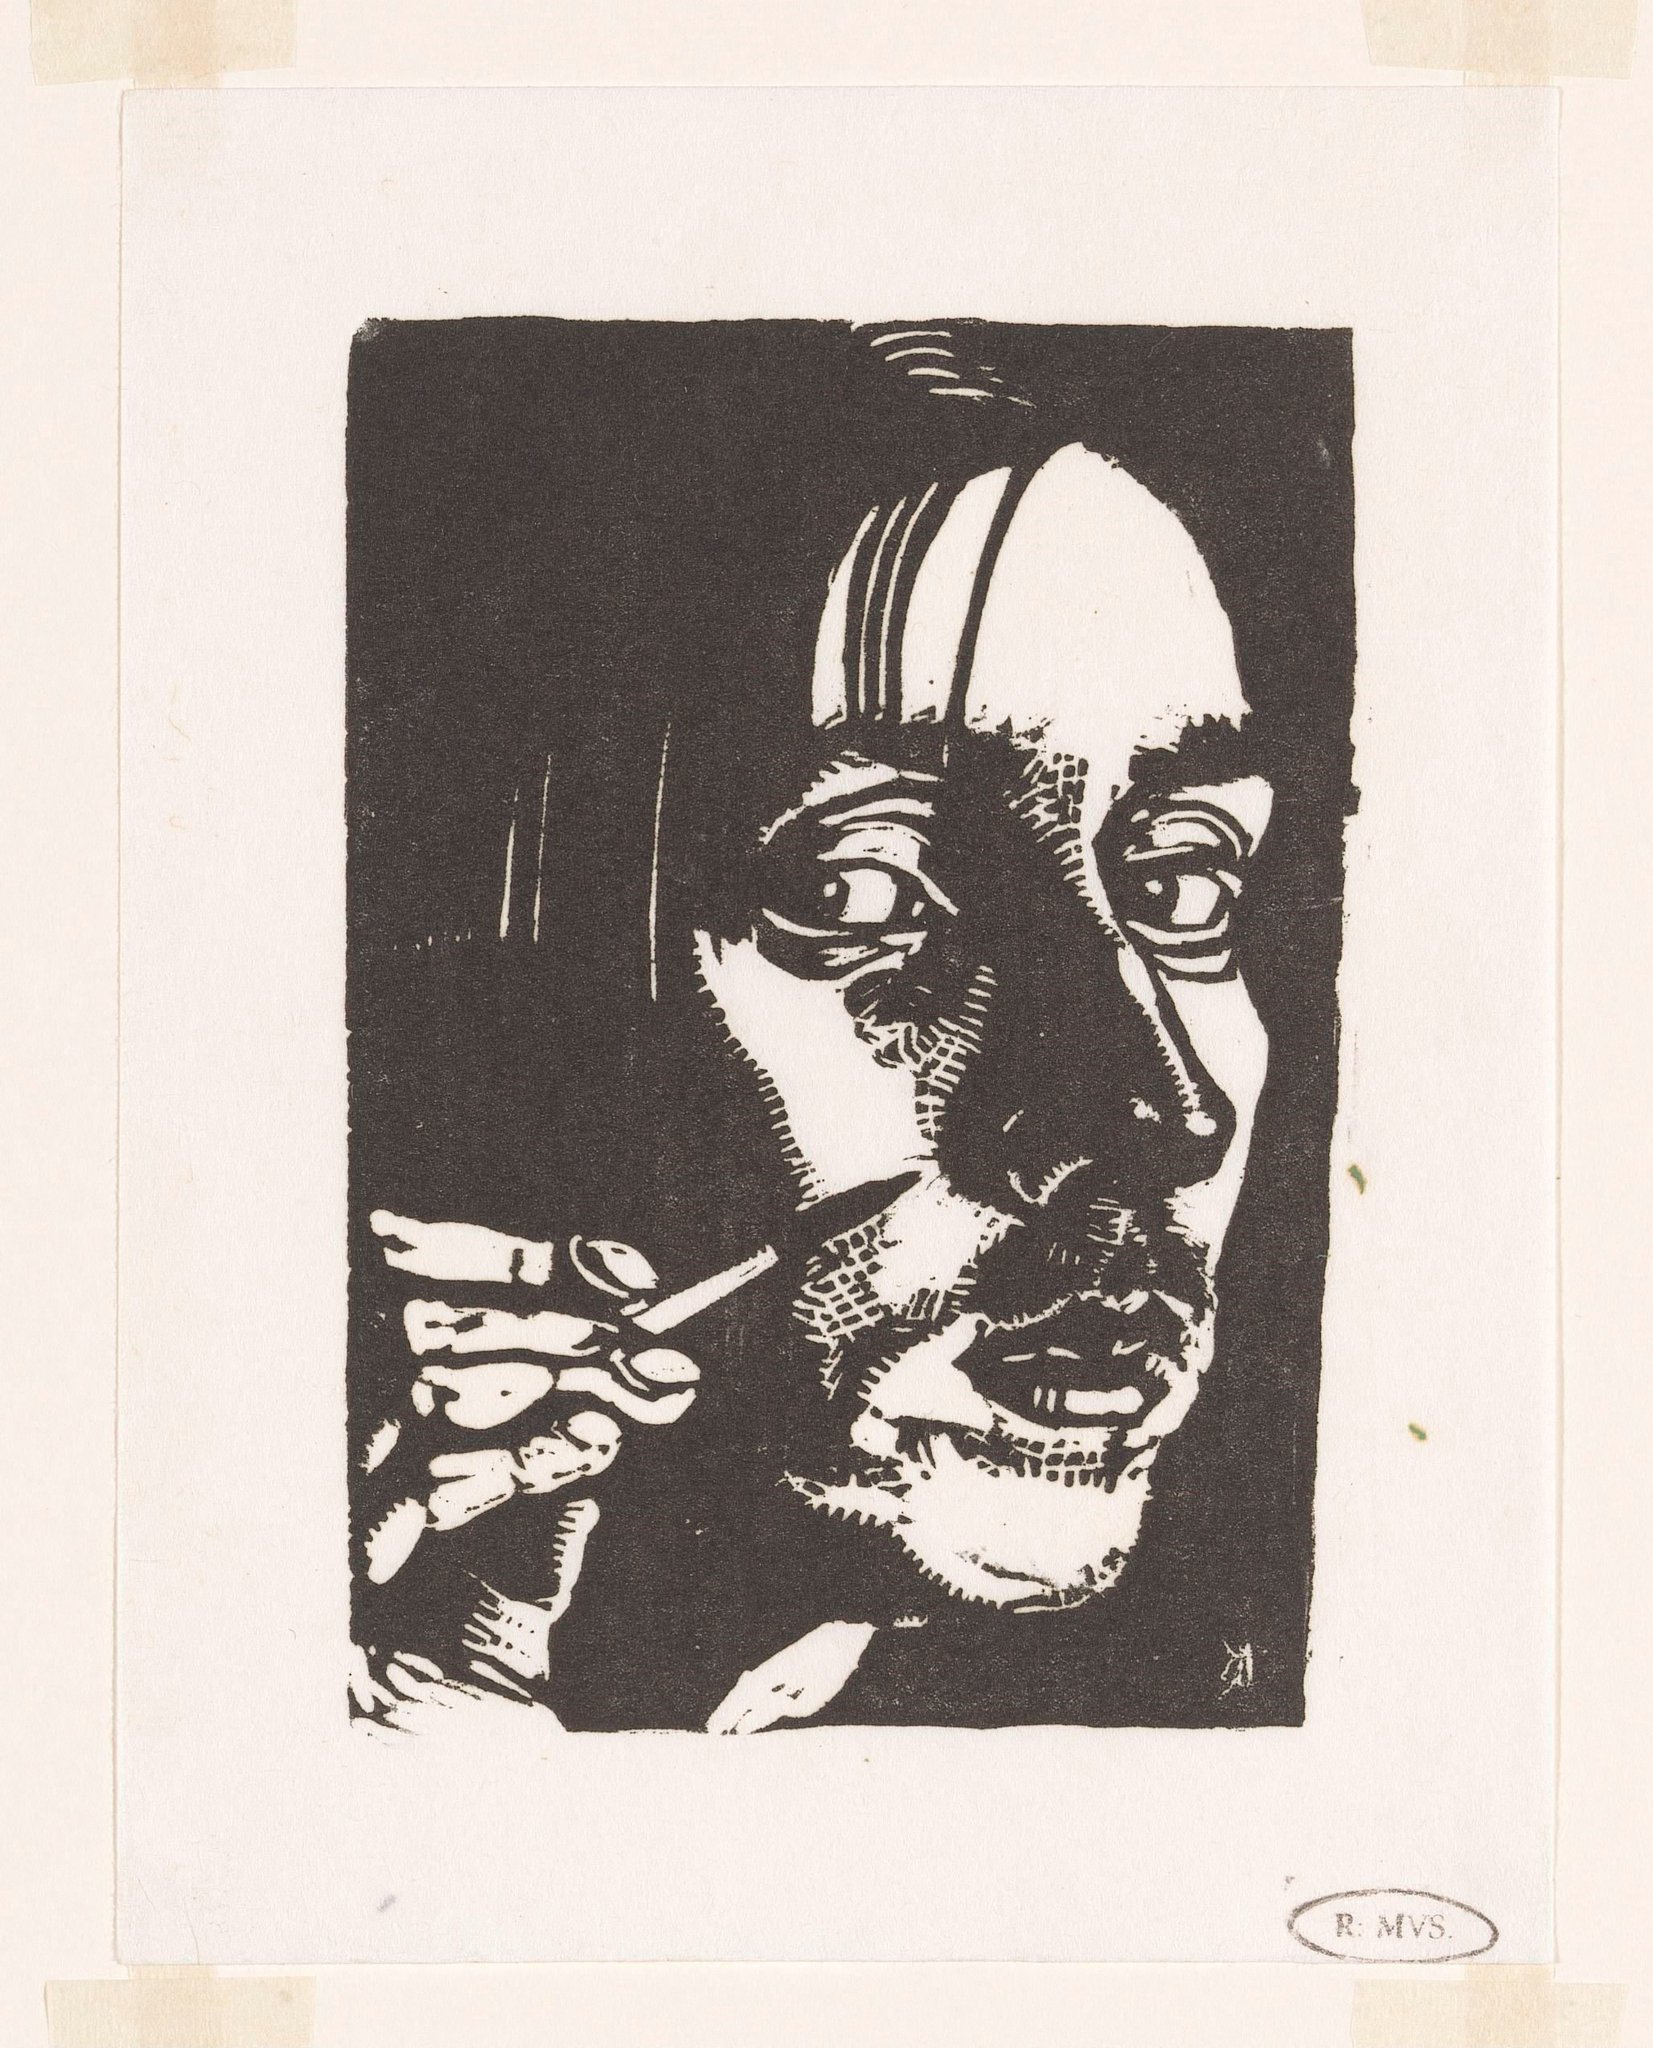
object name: print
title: Zelfportret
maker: dick ket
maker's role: draughtsman, print maker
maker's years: 1902-1940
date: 1930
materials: paper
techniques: linocut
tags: den helder, print maker, draughtsman, dick ket, portrait, self-portrait of artist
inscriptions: collector's mark: Lugt 2228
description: Een zelfportret van Dick Ket, die een penseel voor zijn gezicht houdt.